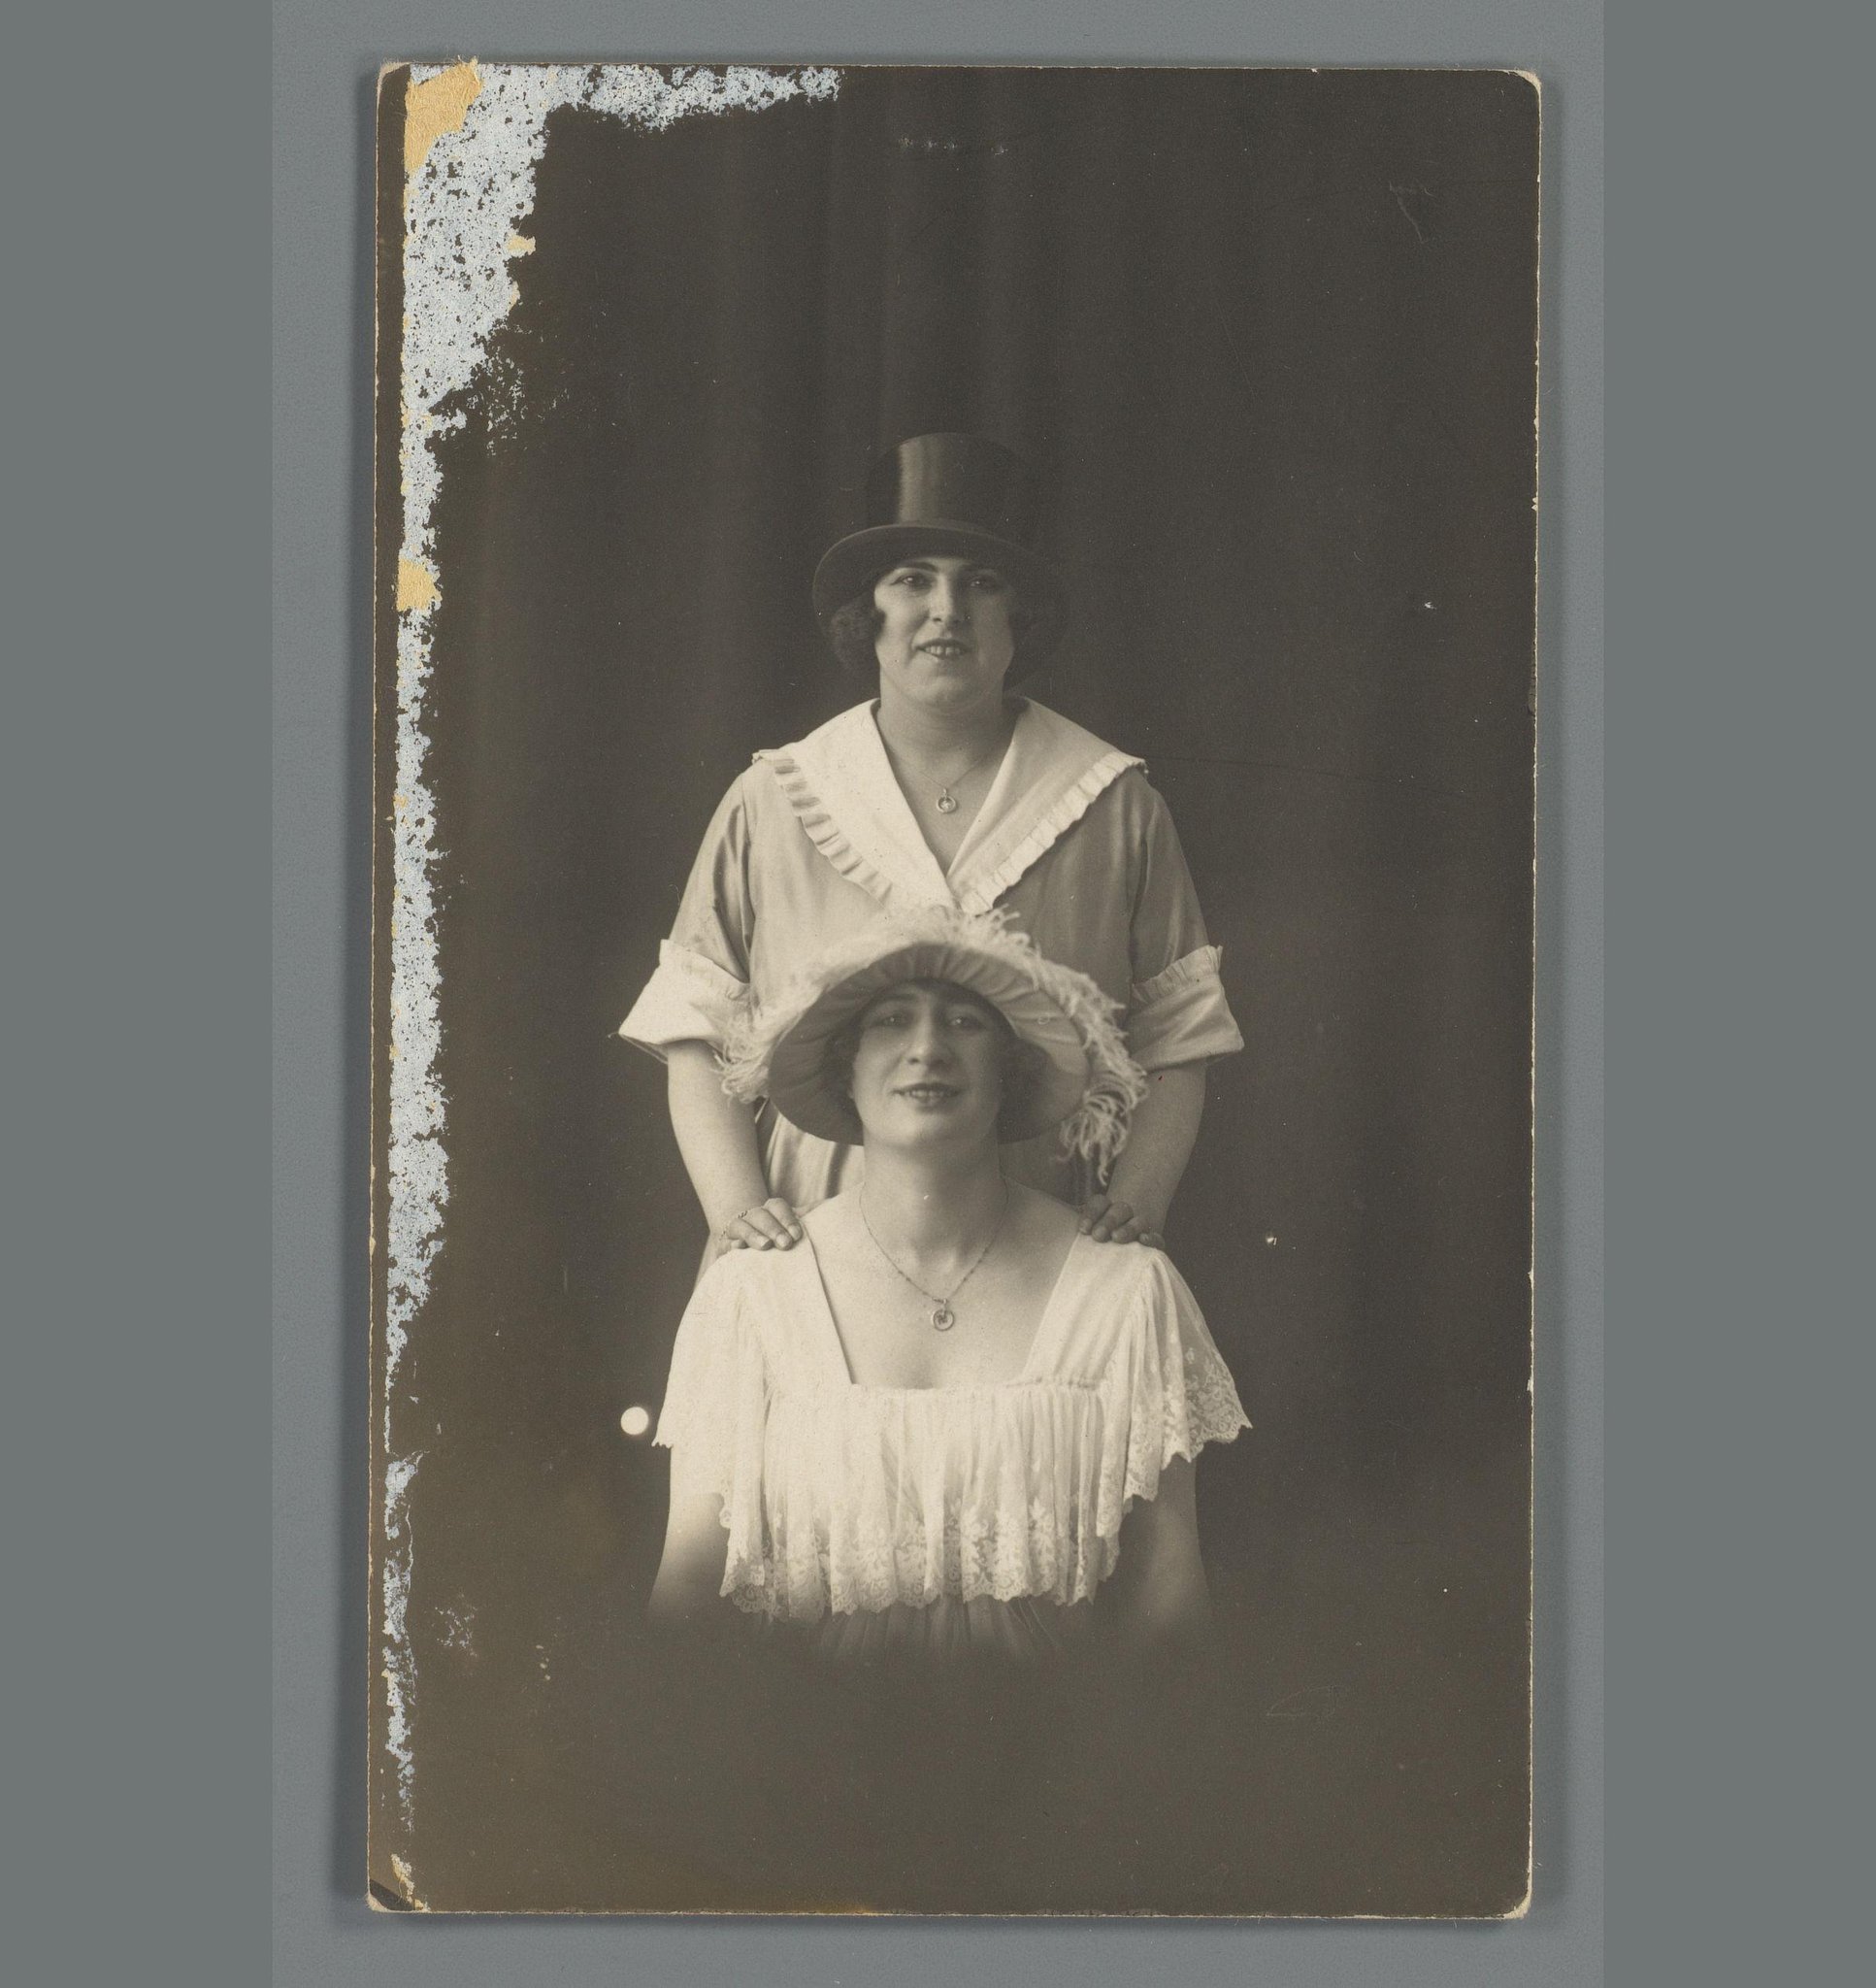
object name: ansichtkaart, prentbriefkaart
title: Portret van Henny en Cato Merks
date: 1911-1934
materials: paper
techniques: gelatin silver print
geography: rotterdam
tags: historical persons - bb - woman, portrait of cabaret-artiste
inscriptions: inscription: ‘Henny en Cato Merks’